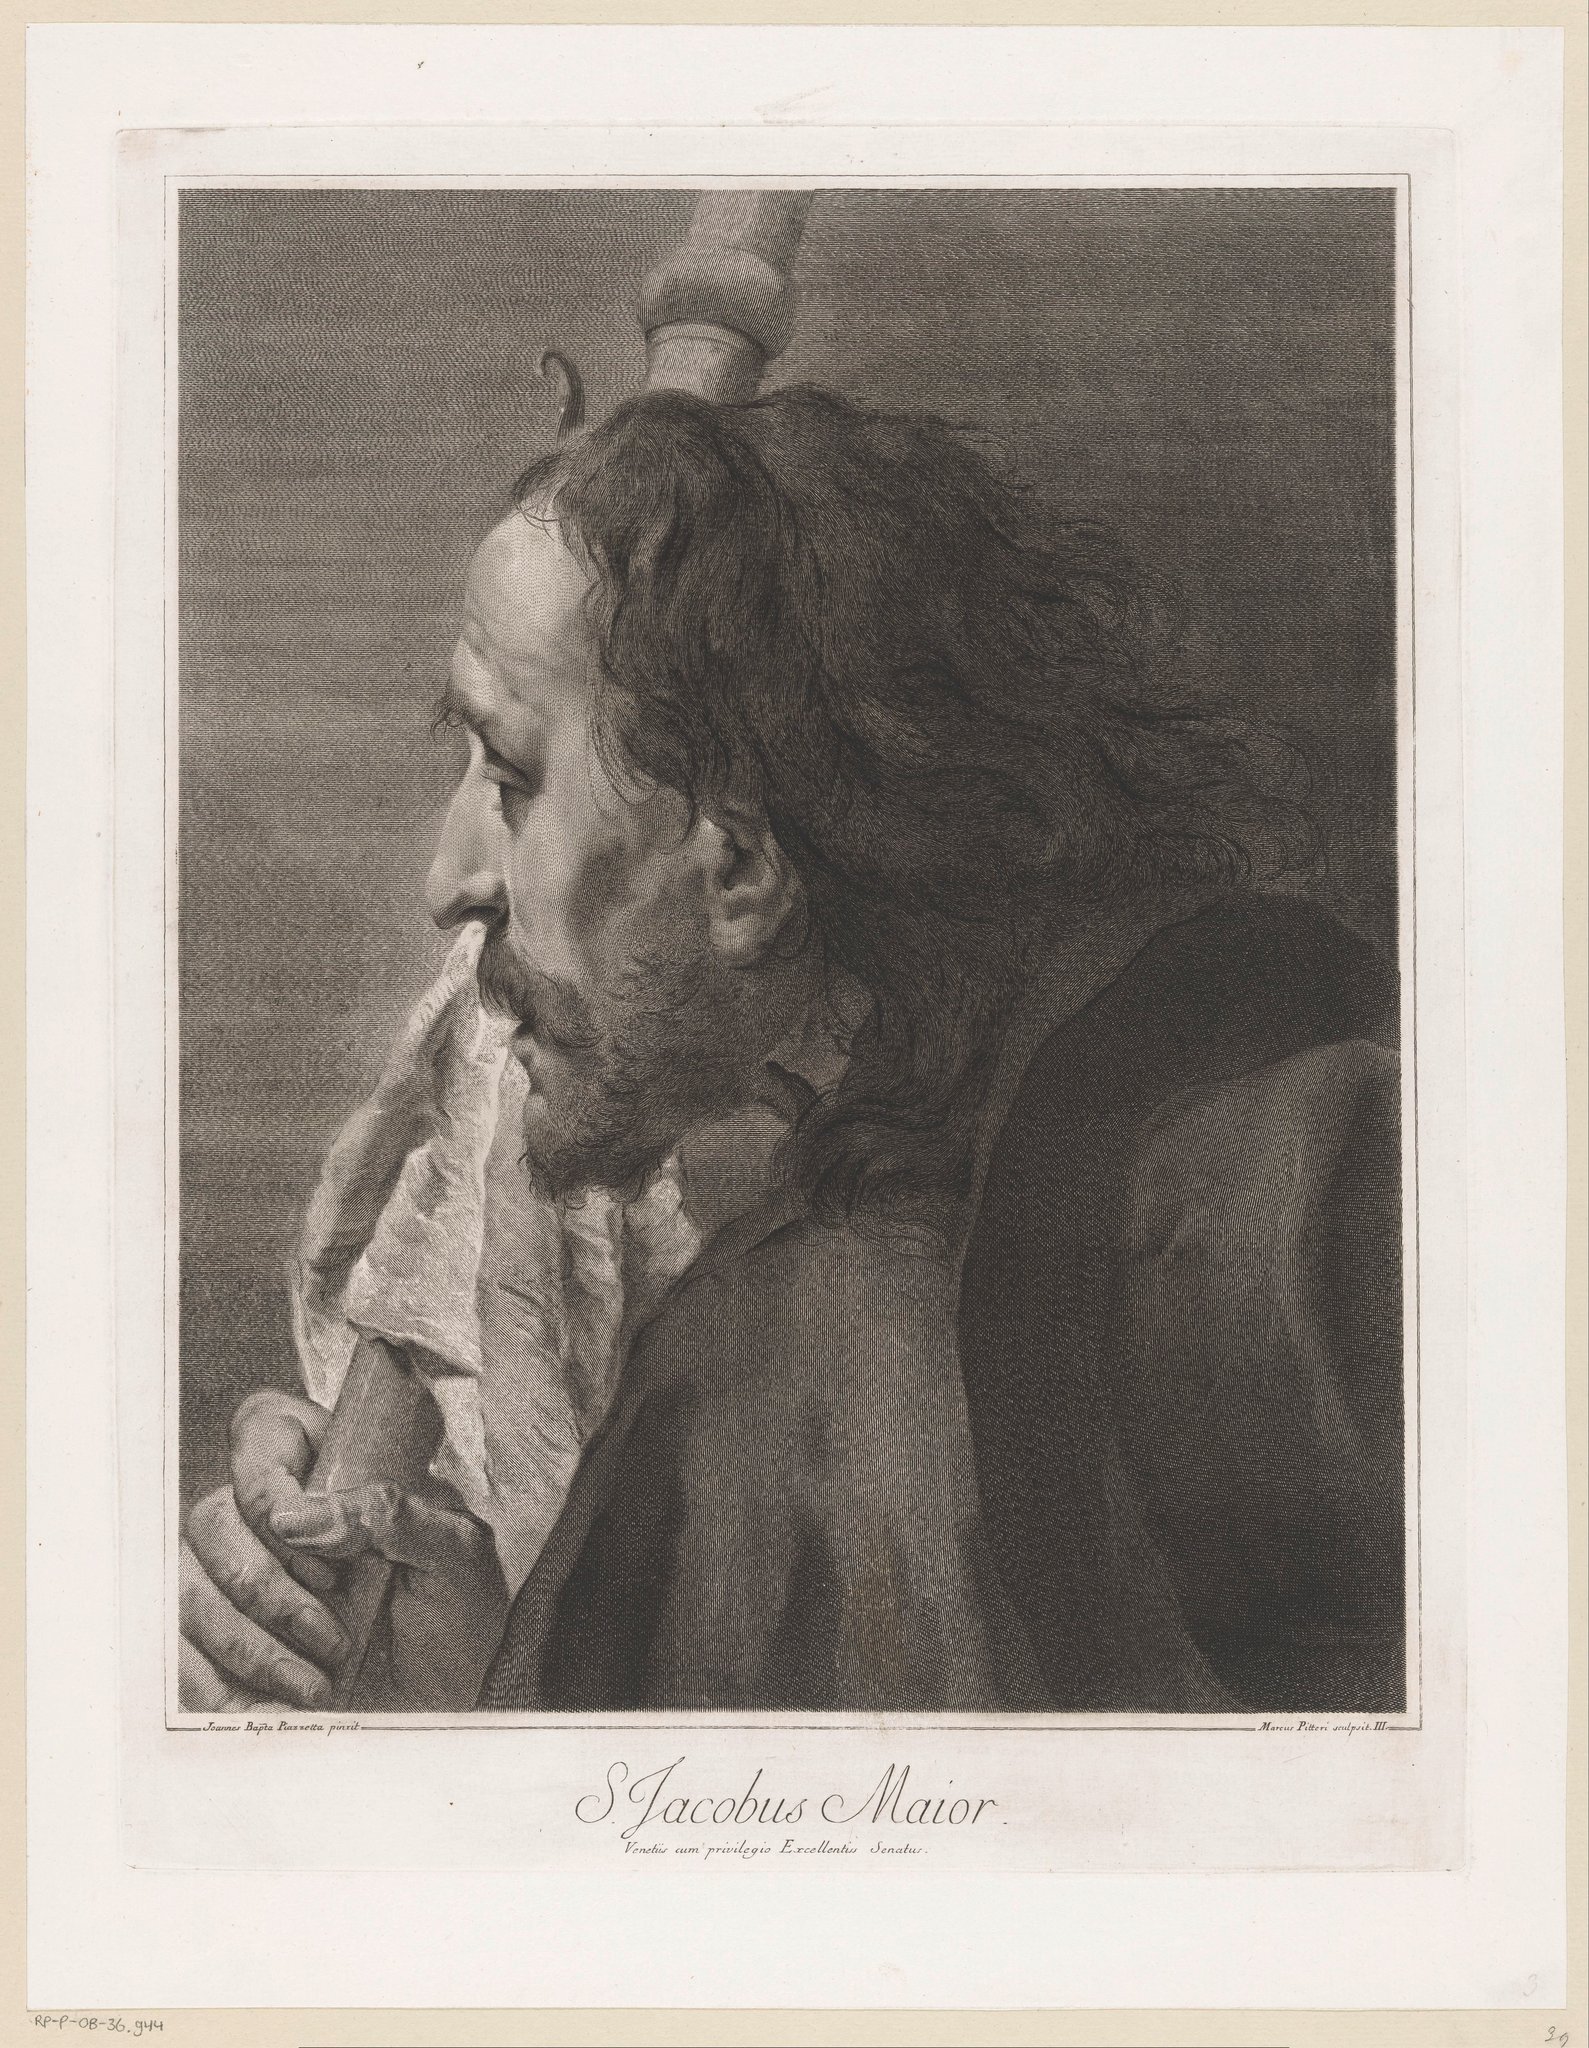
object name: print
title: S. Jacobus Maior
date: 1712-1786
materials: paper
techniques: engraving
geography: venice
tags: the apostle james the great; possible attributes: book, pilgrim's cloak, hat, shell, staff, and wallet, scroll, sword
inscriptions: collector's mark: Lugt 240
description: Deze prent maakt deel uit van een reeks van 12 prenten.